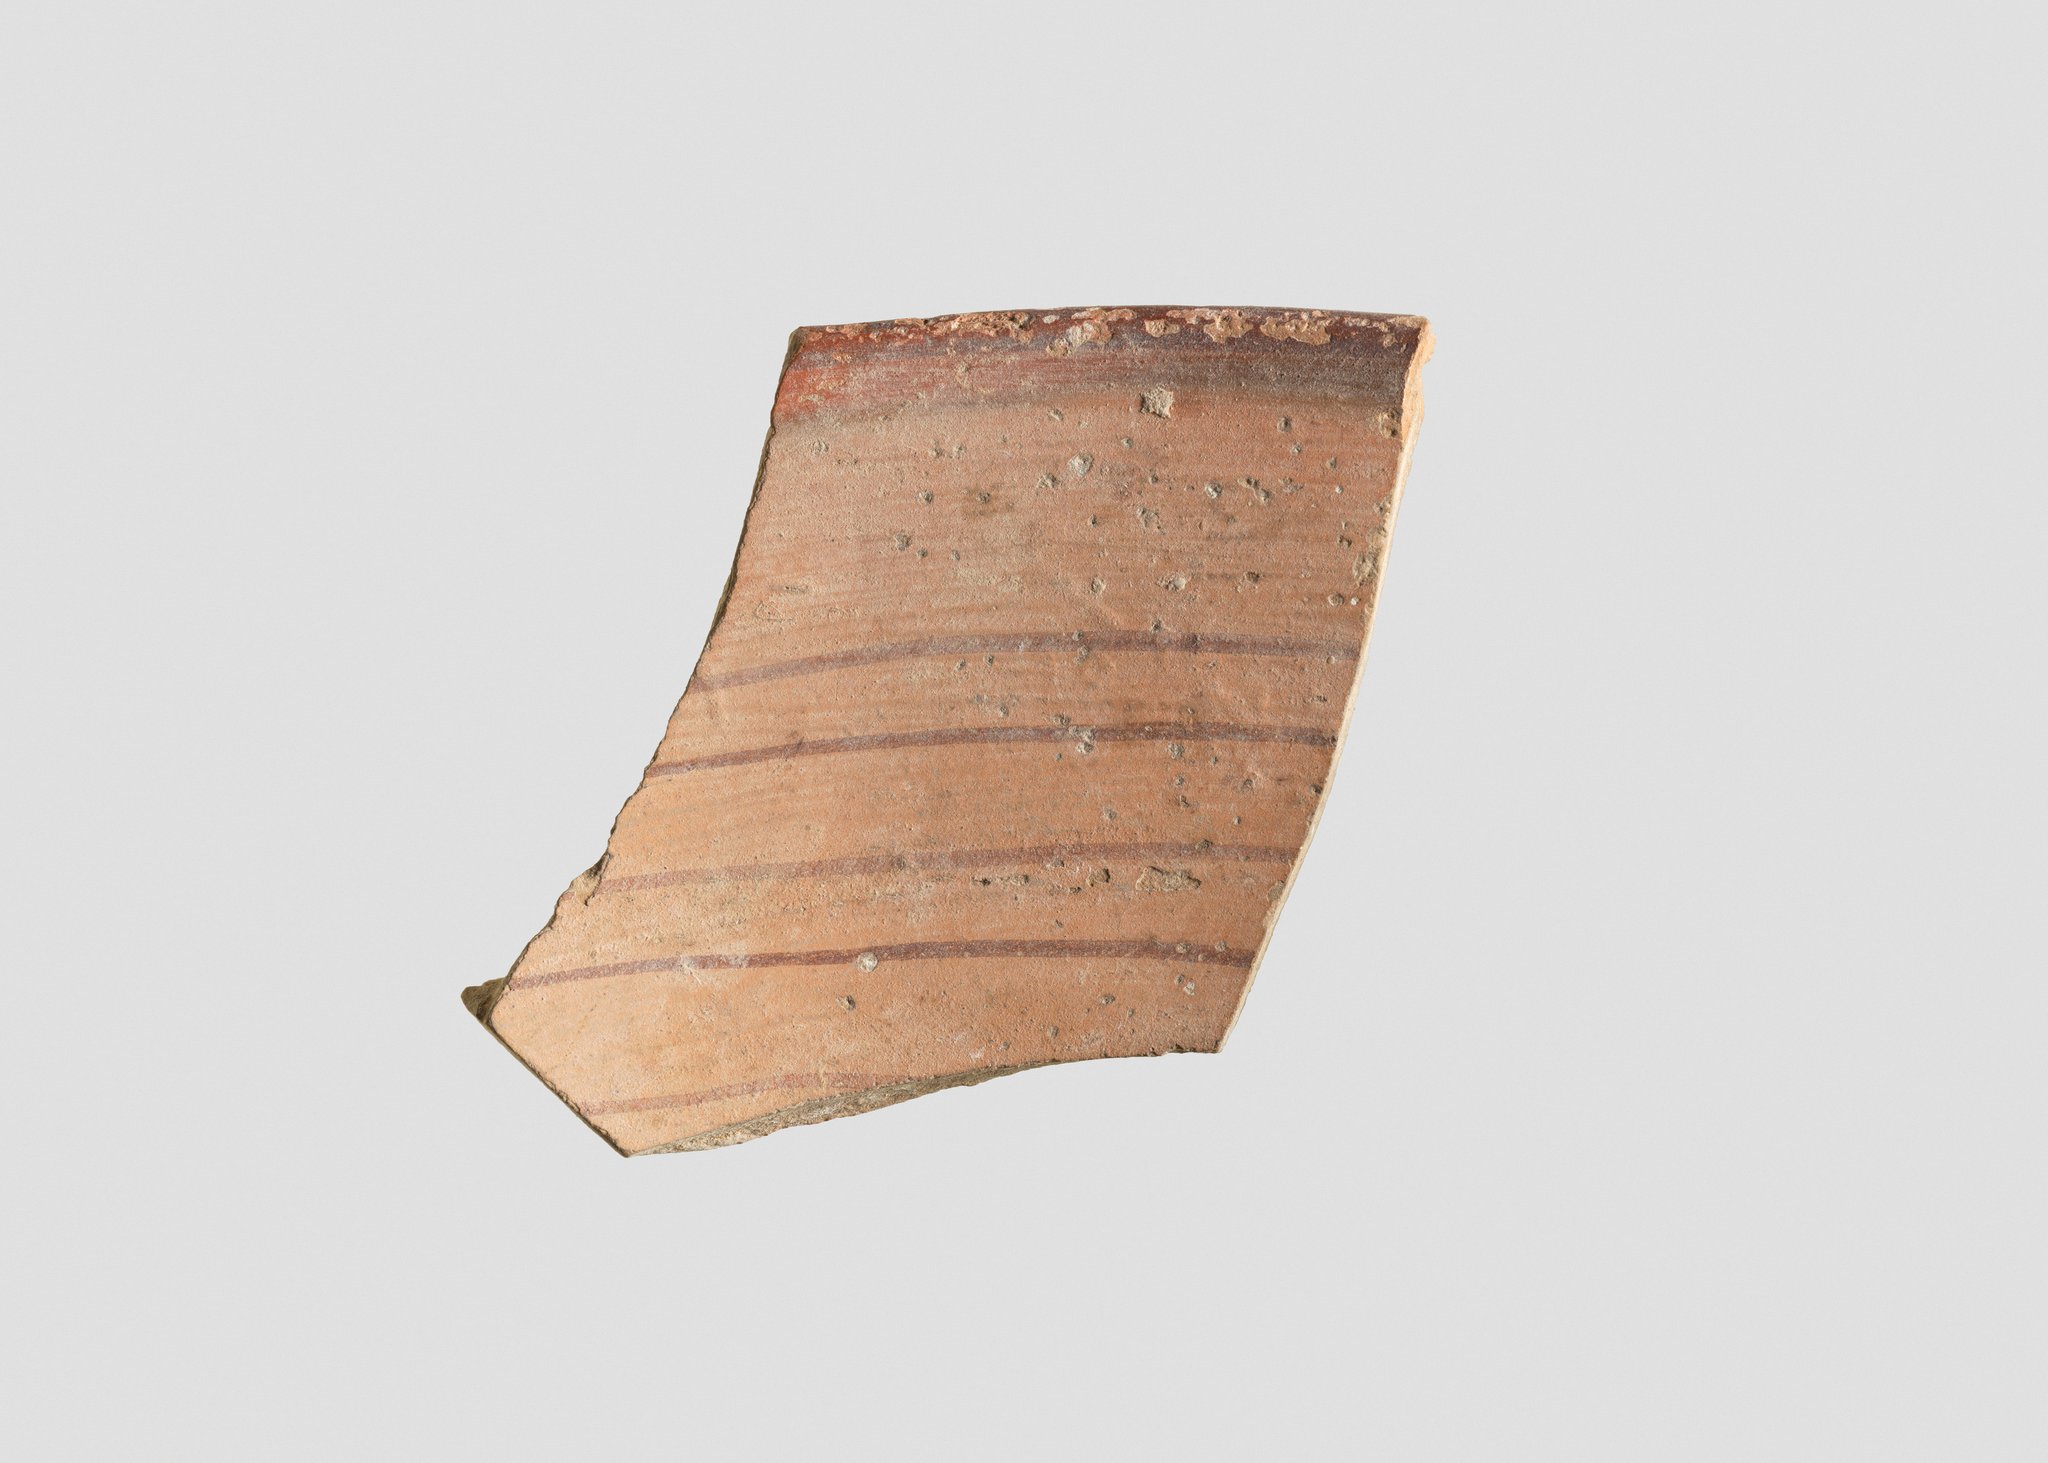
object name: sherd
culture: indus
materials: ceramic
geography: indus region